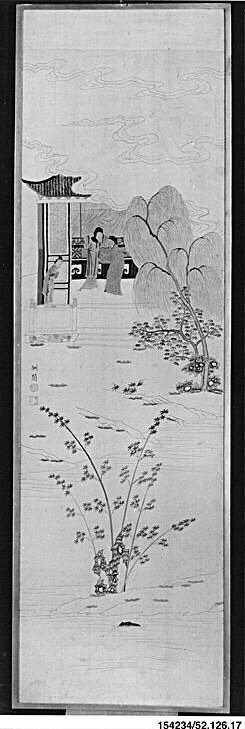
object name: screen panel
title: Screen Panel from Set of Six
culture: chinese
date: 1767-1833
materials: silk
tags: men,women